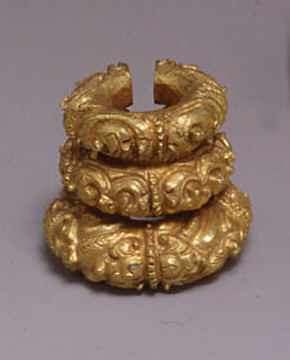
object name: fastener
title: Weighted Fastener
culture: indonesian, javanese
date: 701-933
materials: gold